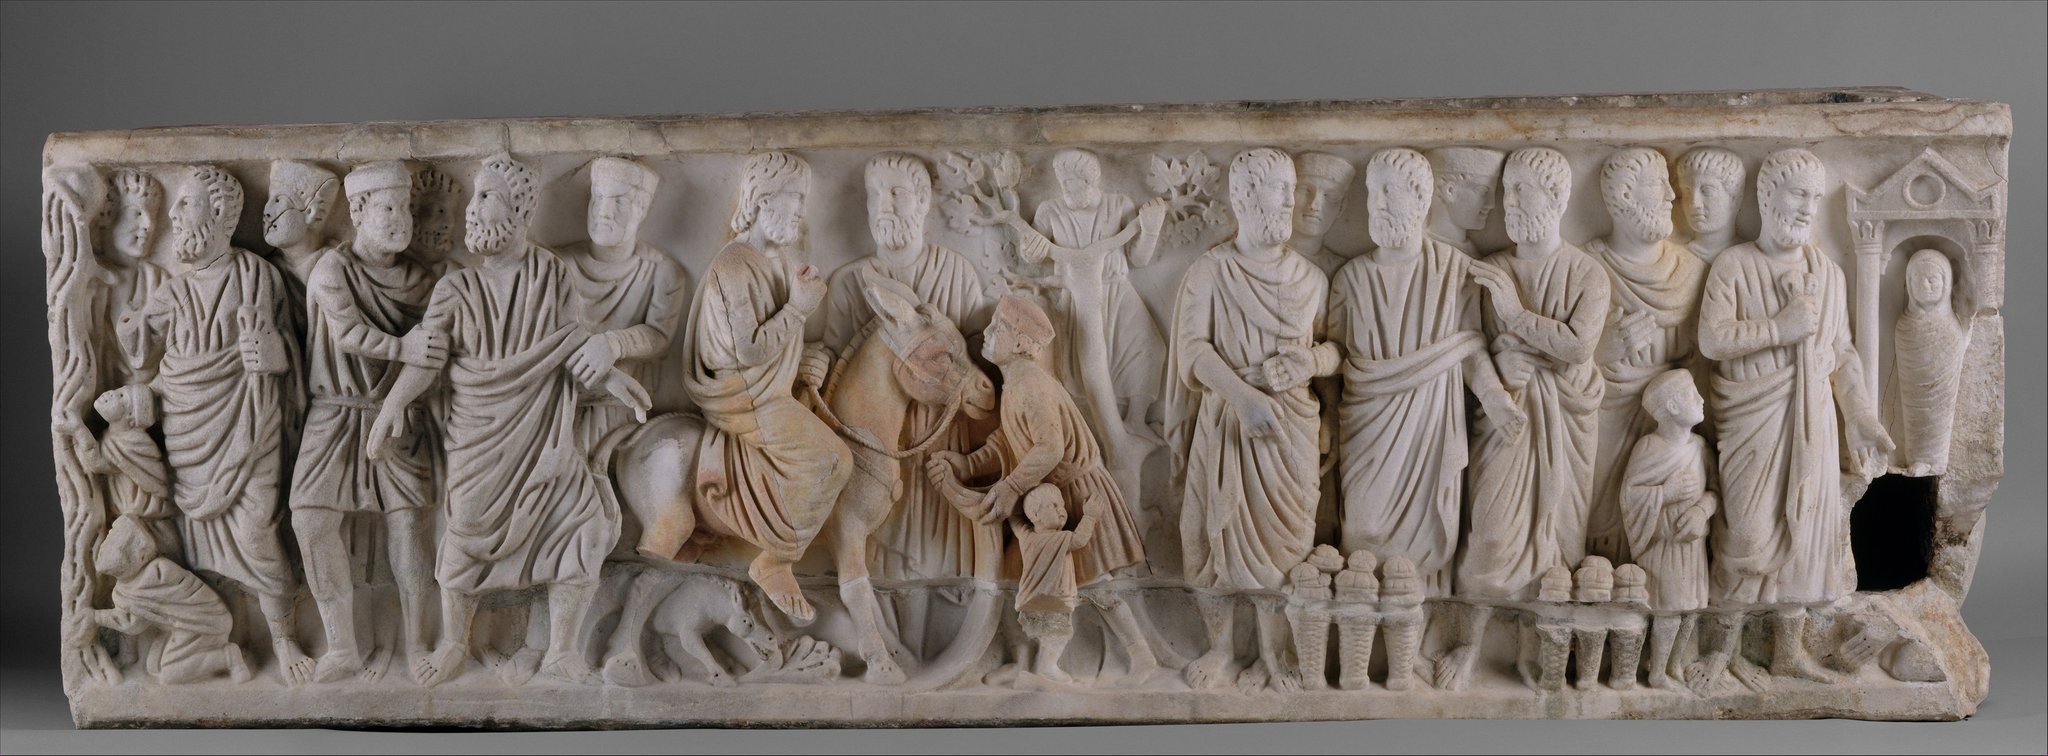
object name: sarcophagus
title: Sarcophagus with Scenes from the Lives of Saint Peter and Christ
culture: roman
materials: marble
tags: children,men,christ,saint peter